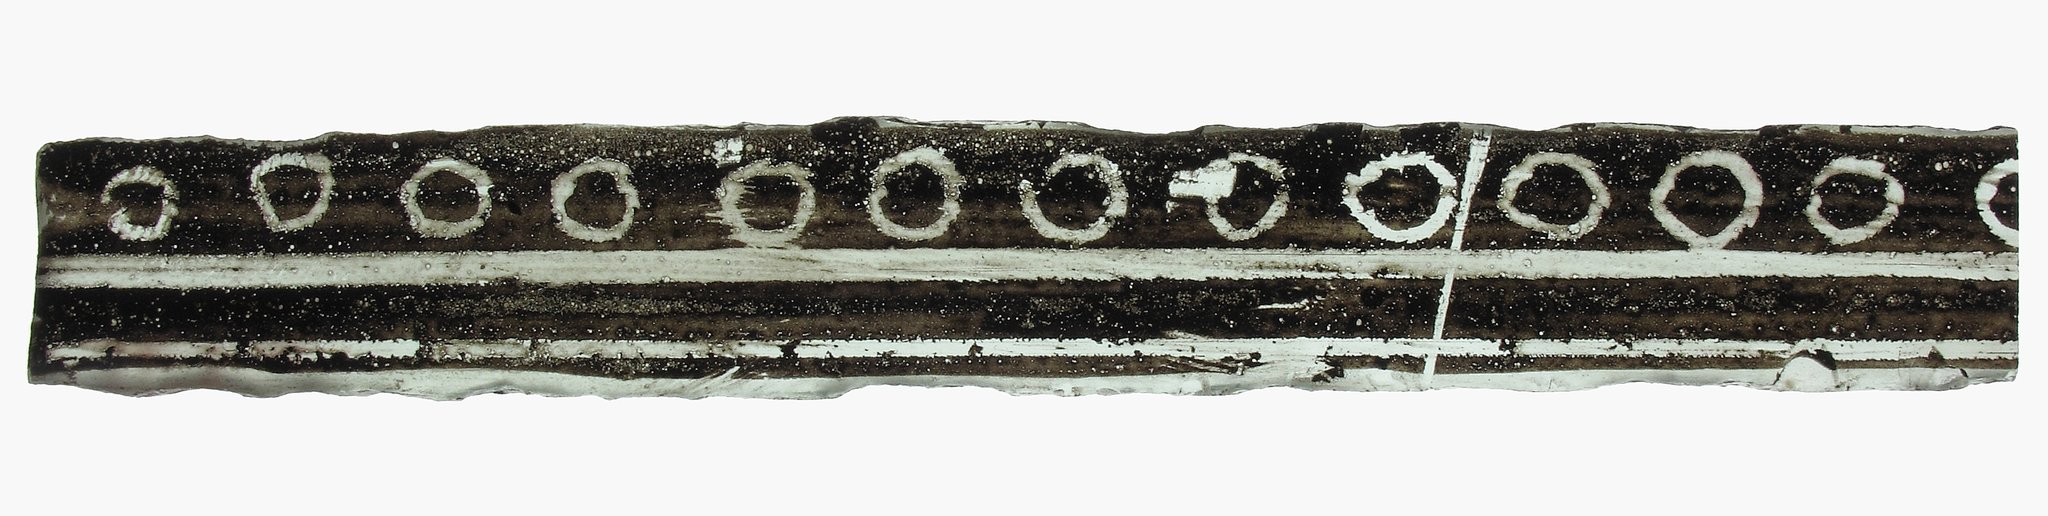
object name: fragment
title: Glass Fragment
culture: european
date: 1301-1500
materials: glass